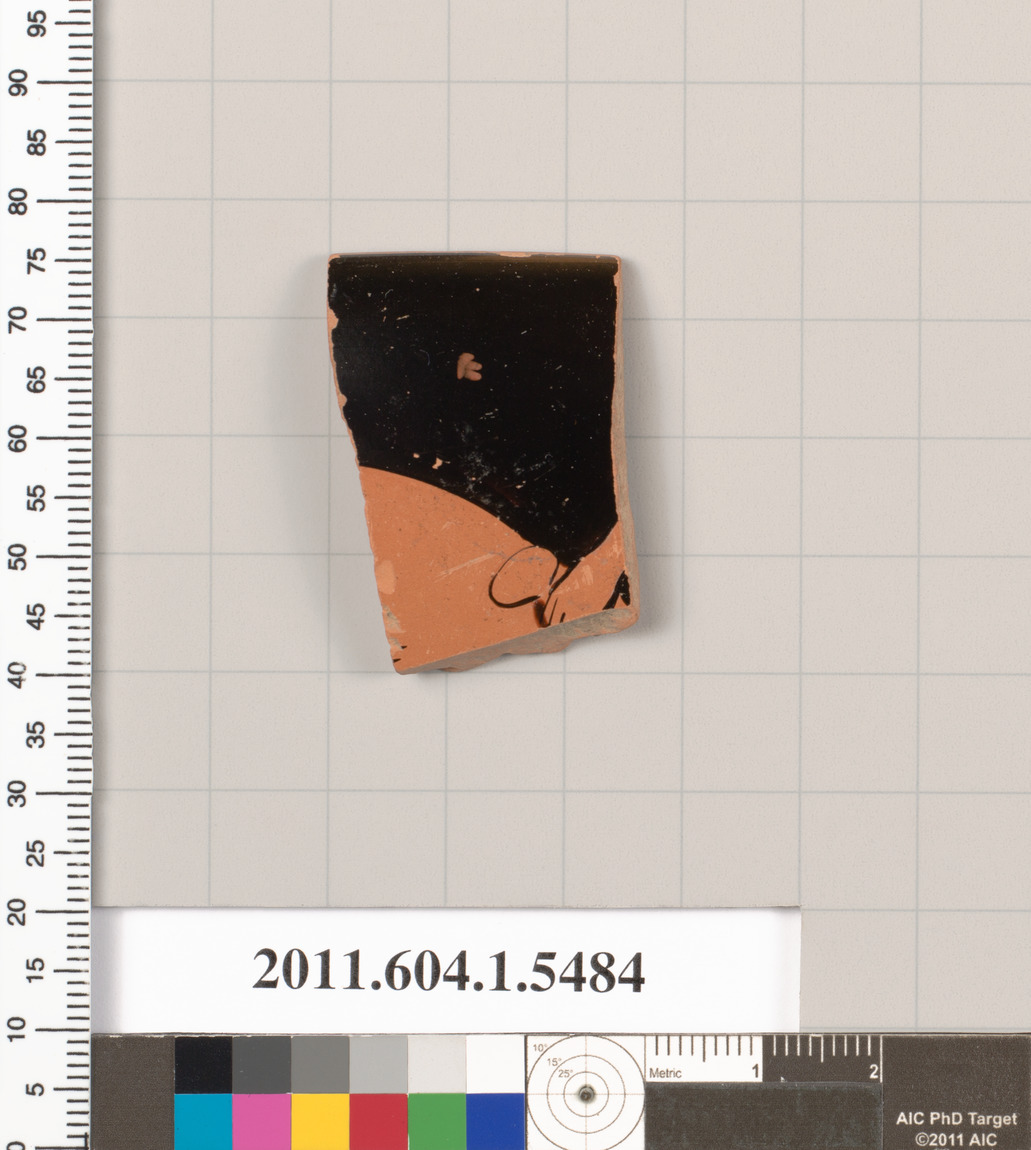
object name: kylix fragment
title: Terracotta rim fragment of a kylix (drinking cup)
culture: greek, attic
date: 500-480 BCE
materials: terracotta